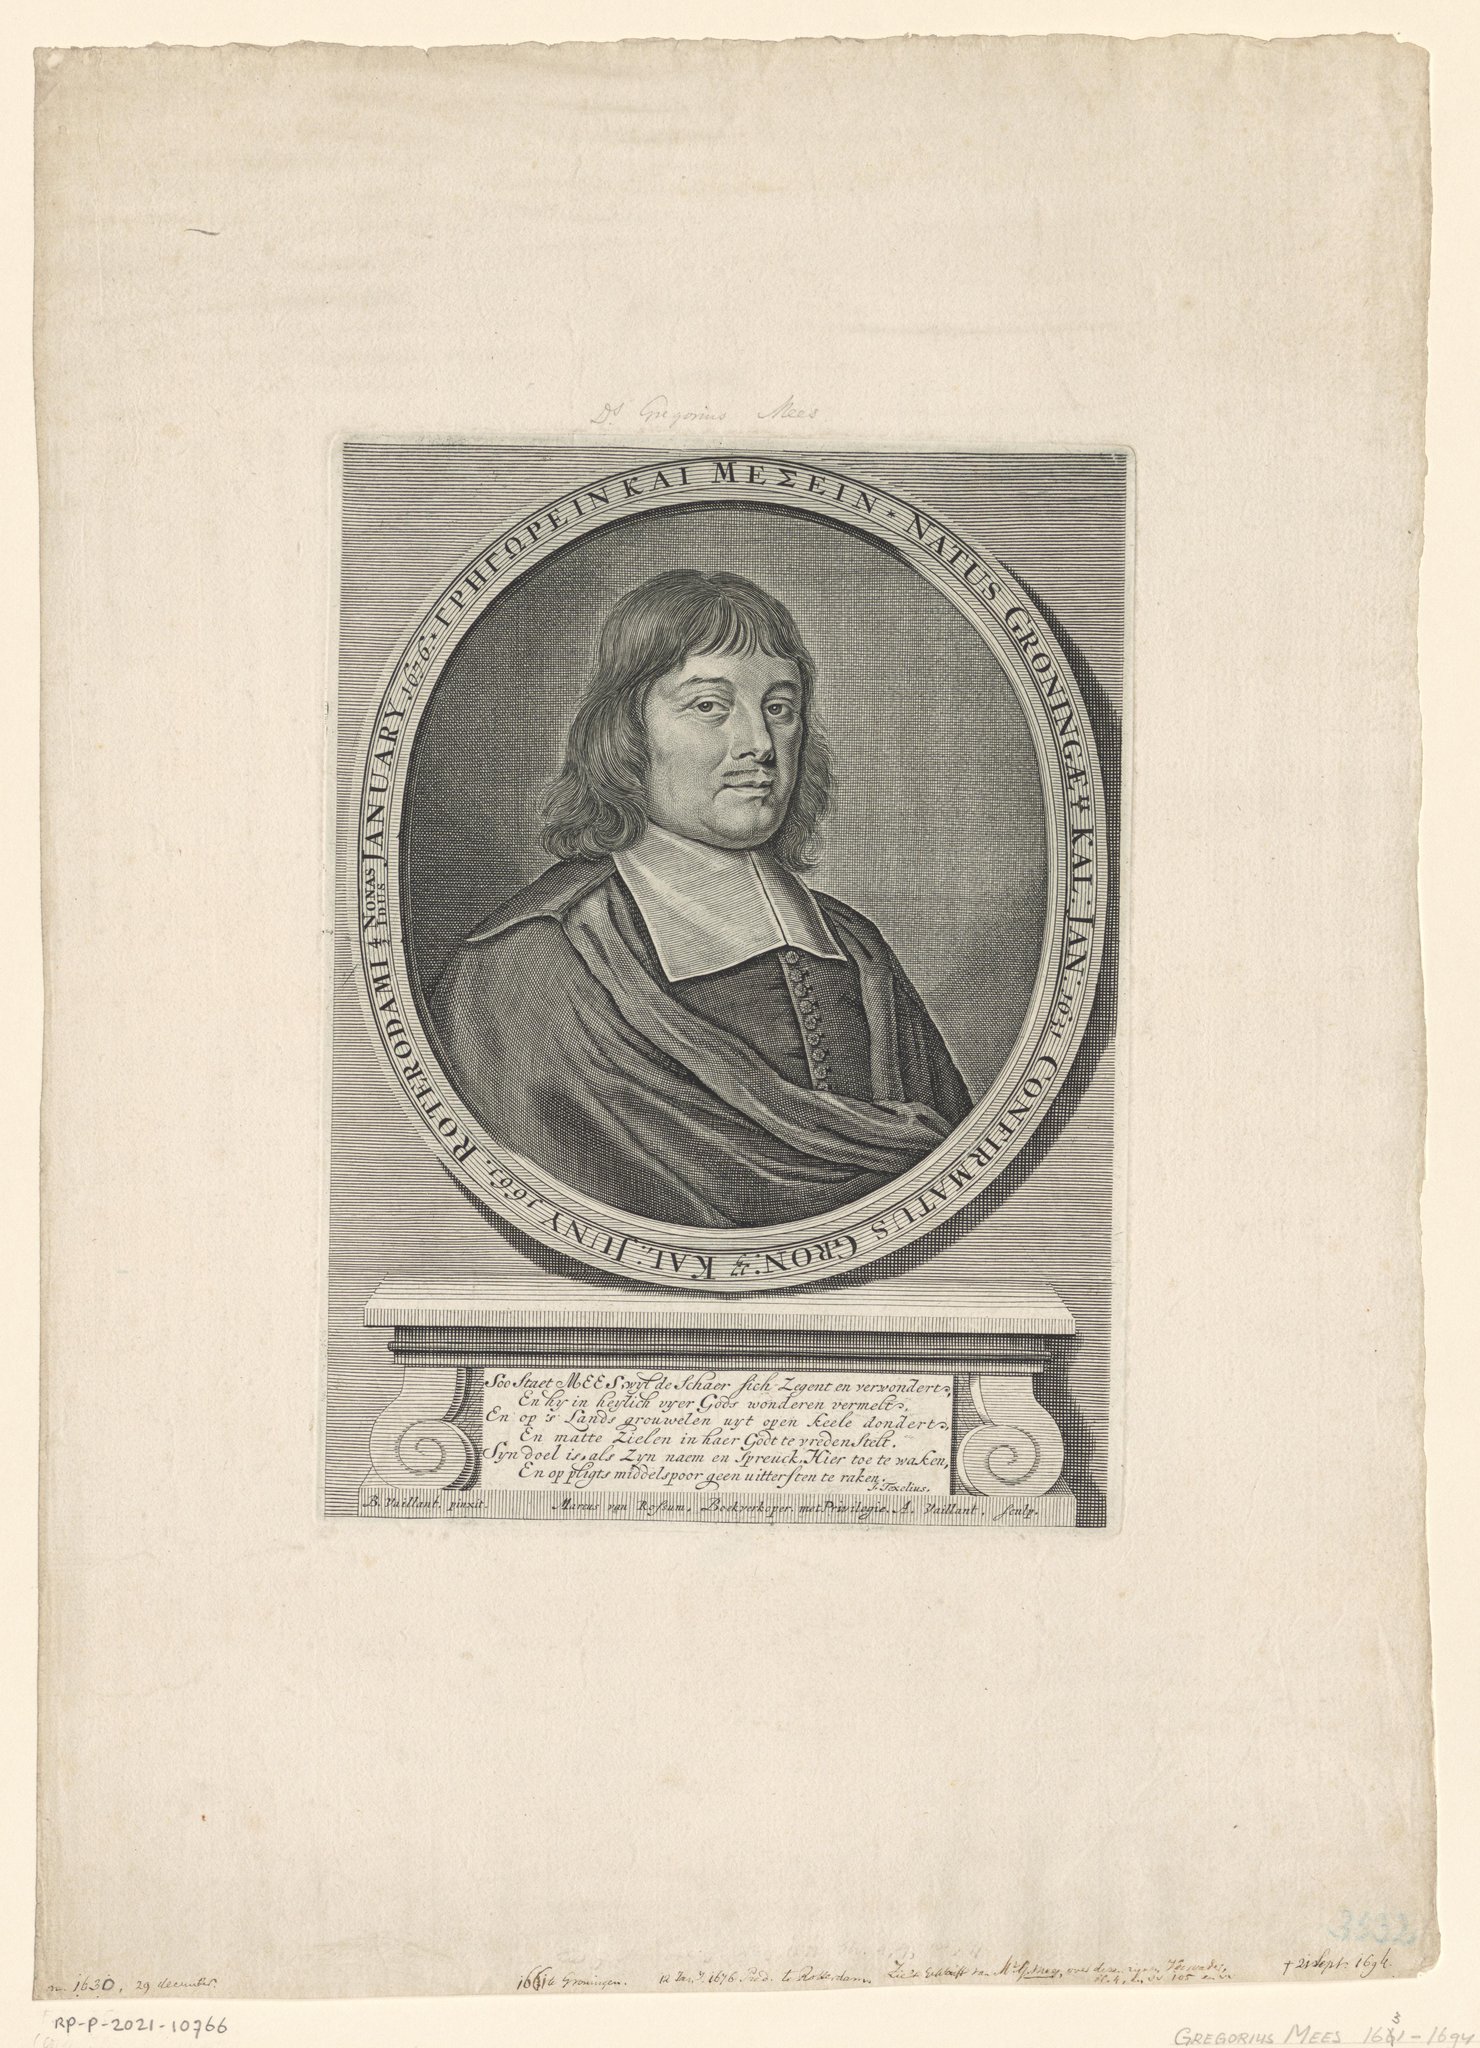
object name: print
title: Portret van Gregorius Mees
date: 1676-1685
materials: paper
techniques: engraving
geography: northern netherlands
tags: gregorius mees, ornament ~ medallion, historical persons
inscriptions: collector's mark: Lugt 2228, inscription: ‘n. 1630, 29 december/ 1661 te Groningen. 12 Jan 1676 Pred. te Rotterdam (...)’